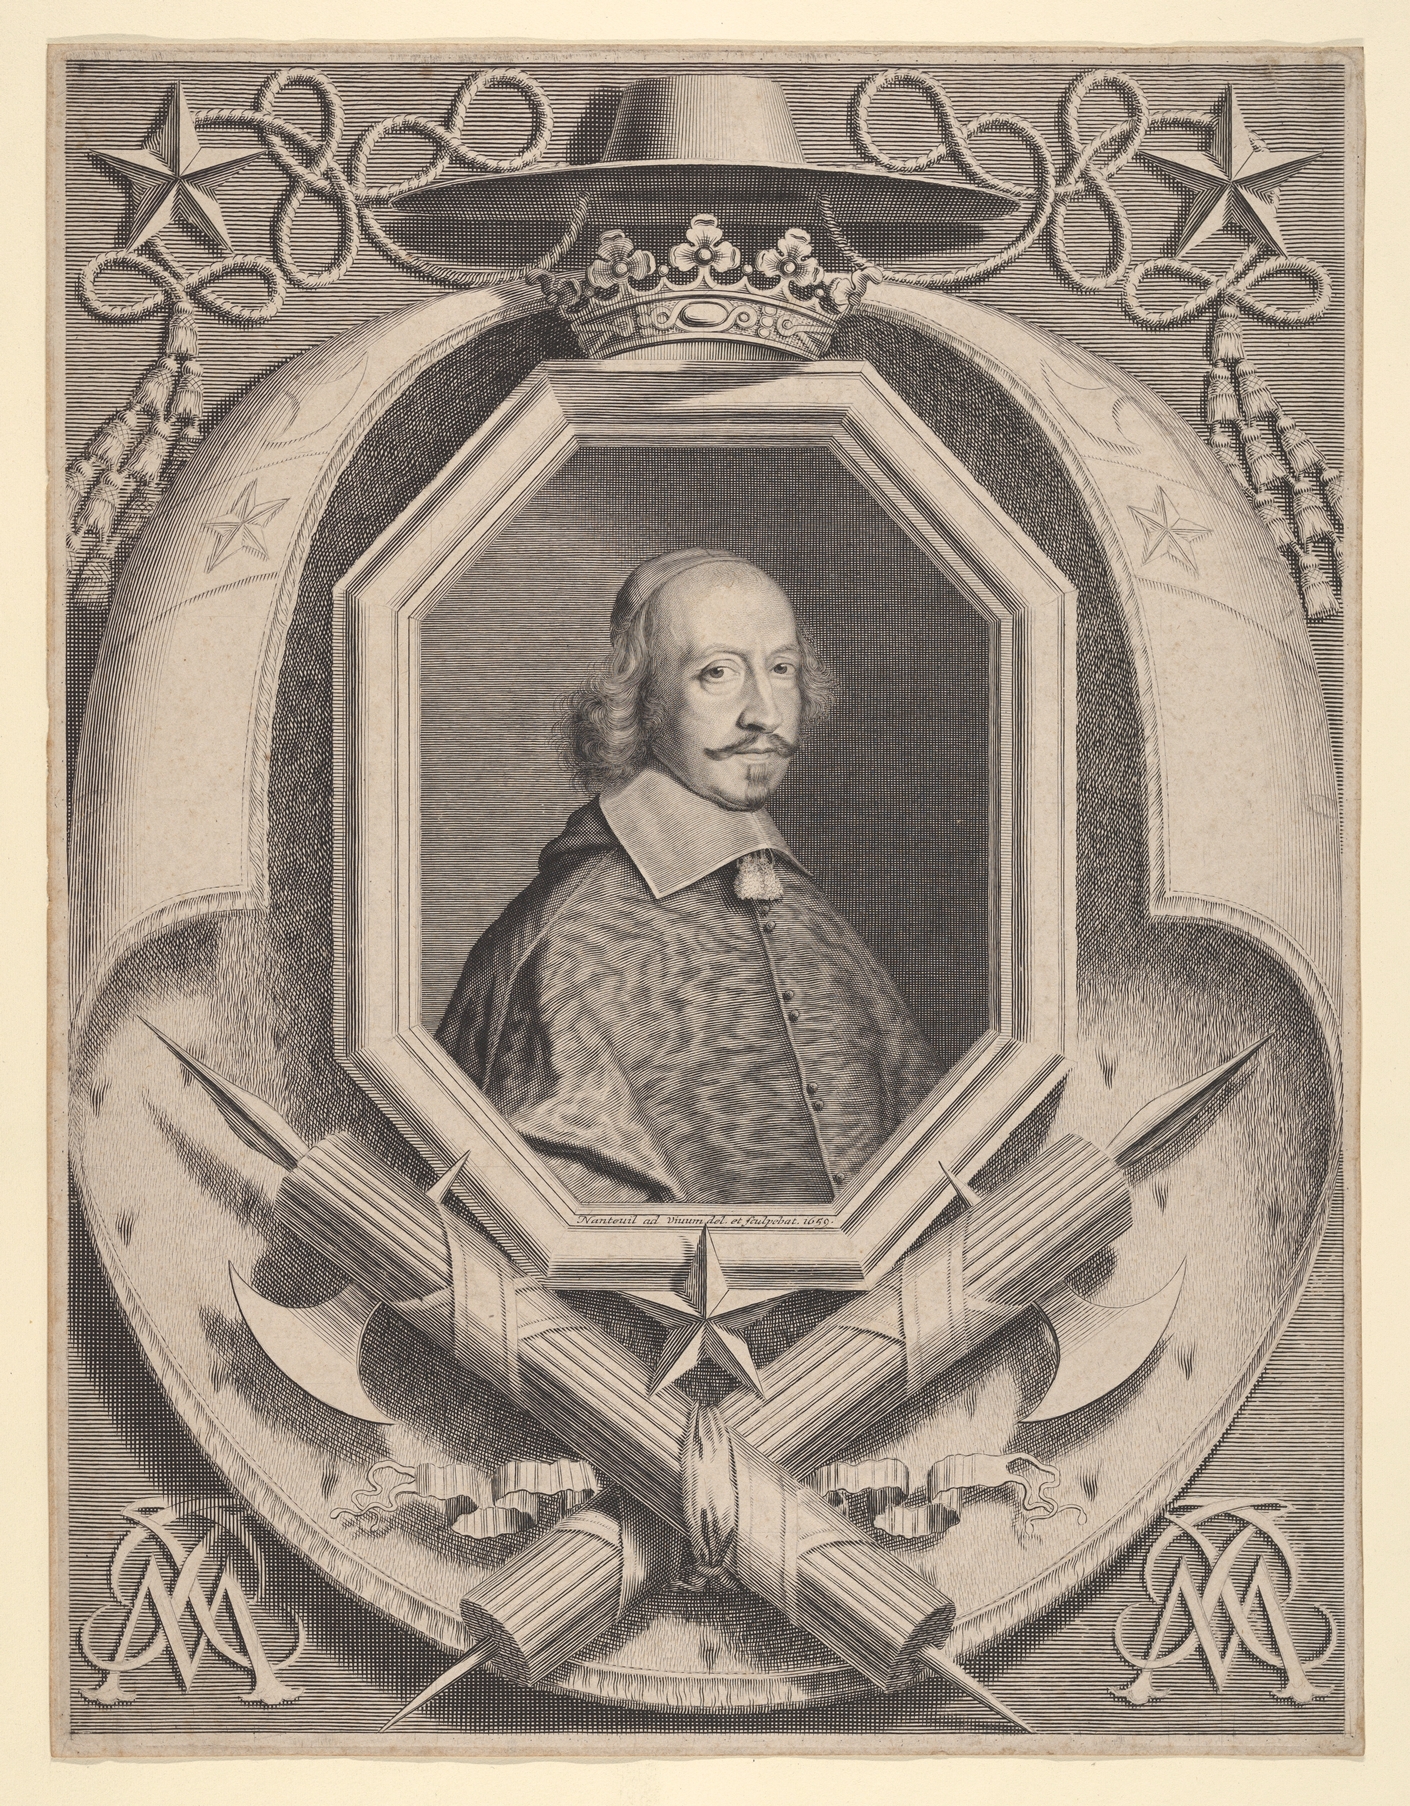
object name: print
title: Cardinal Jules Mazarin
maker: robert nanteuil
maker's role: artist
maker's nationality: french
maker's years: 1623-1678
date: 1659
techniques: engraving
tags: men,portraits,insignia